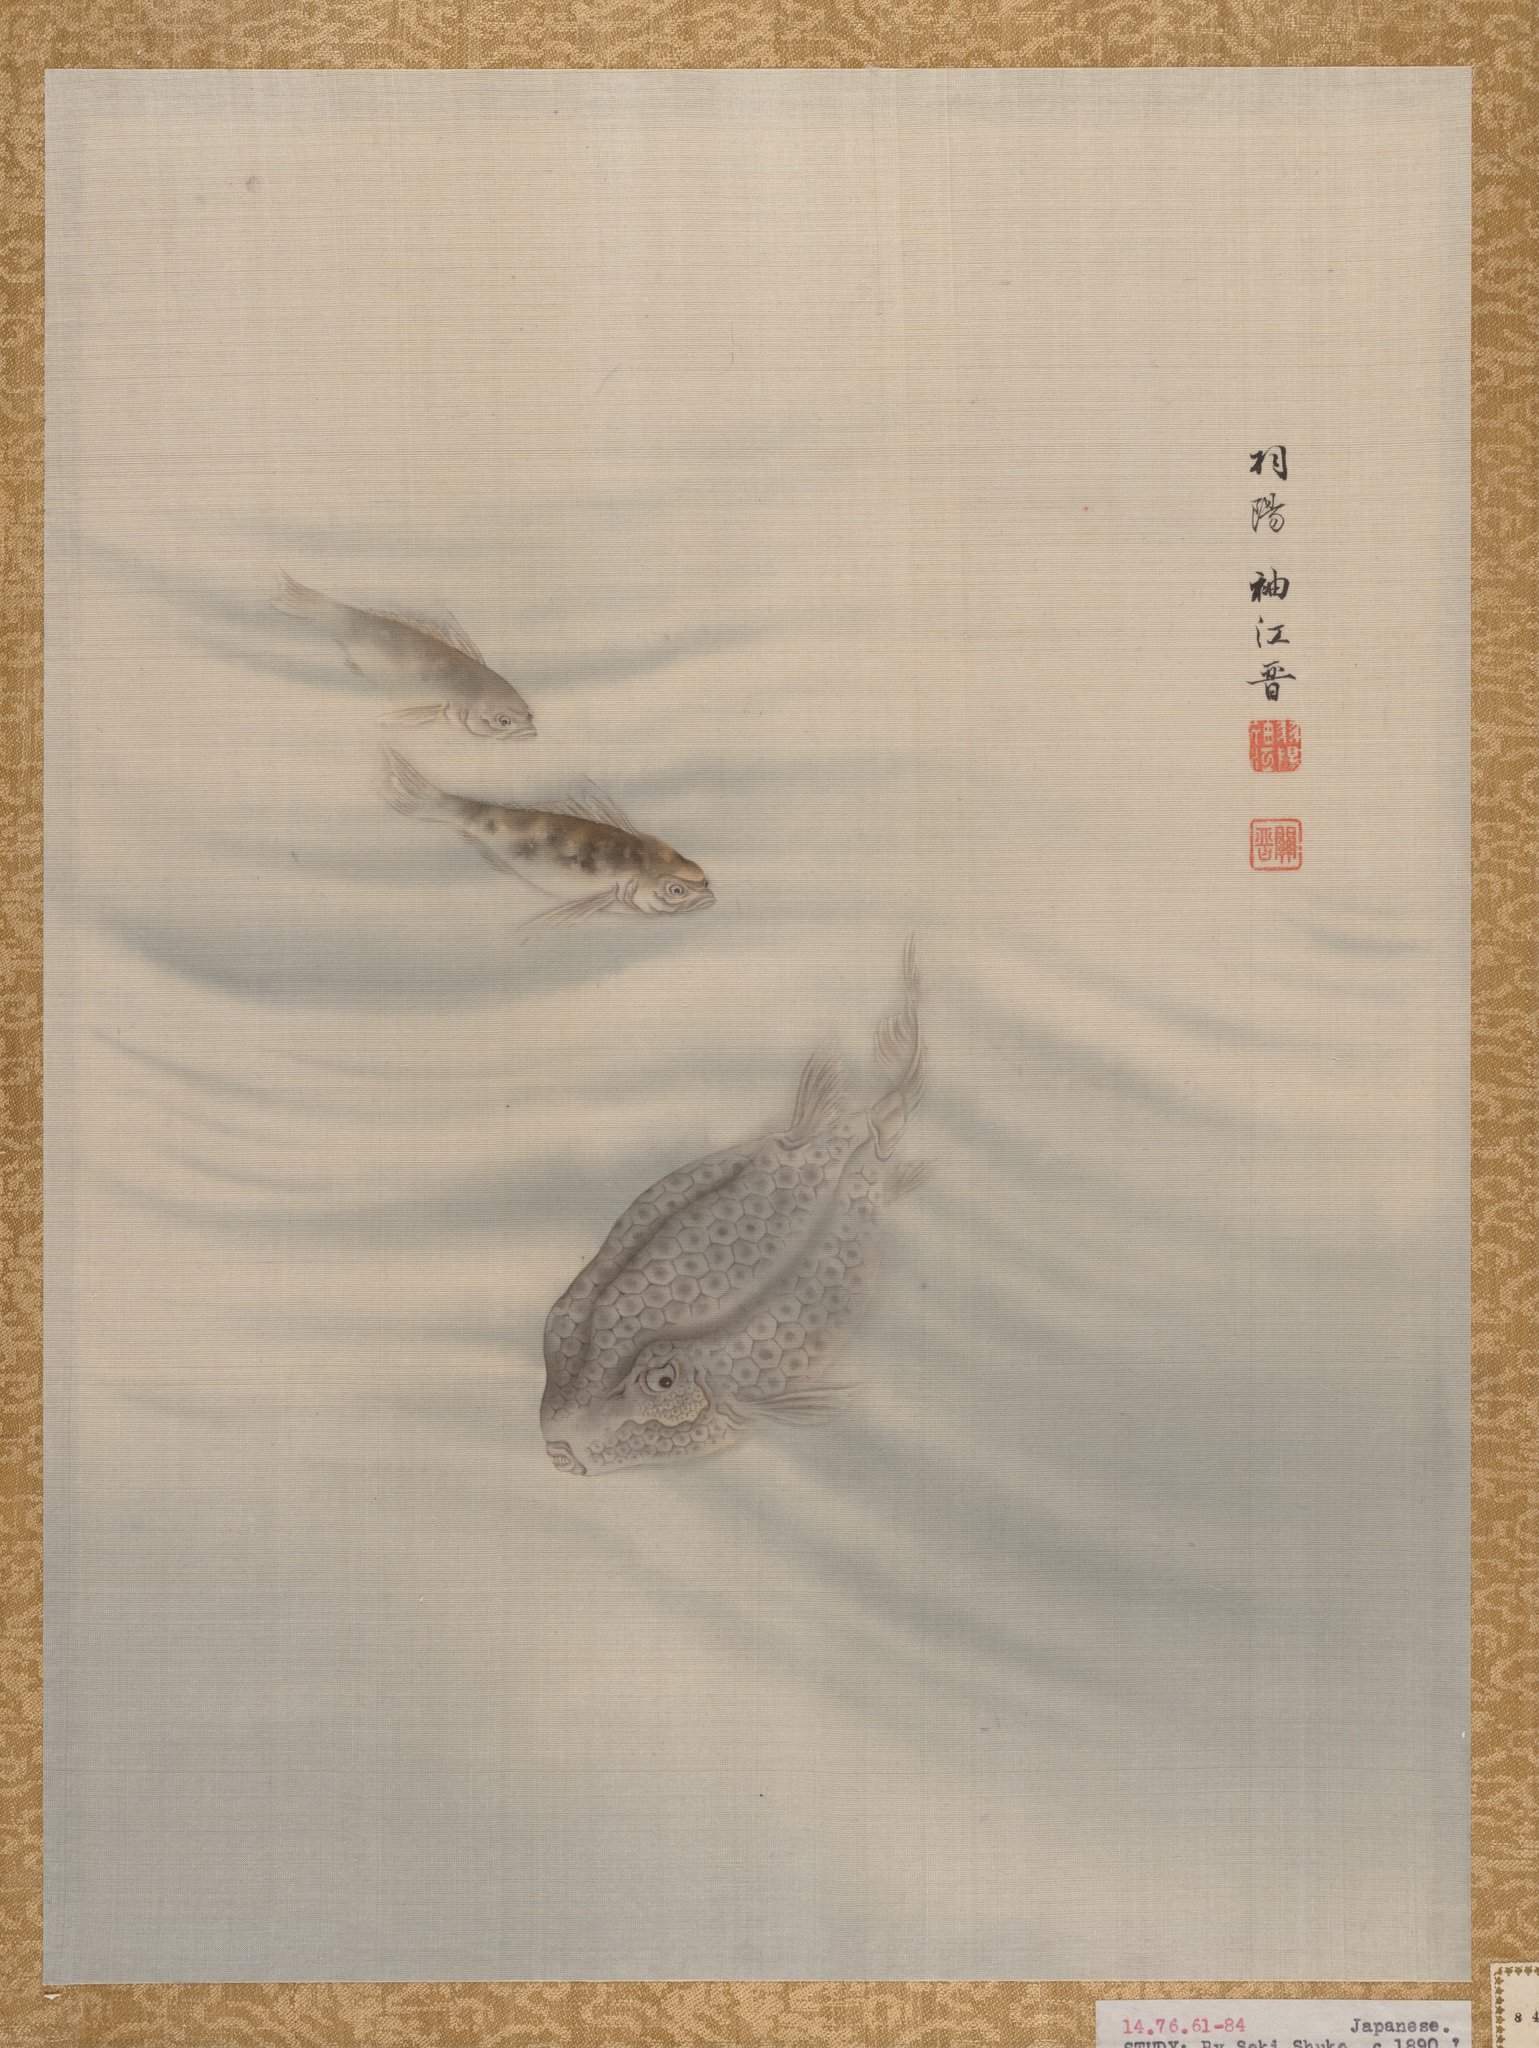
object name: album leaf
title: Fishes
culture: japanese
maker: seki shūkō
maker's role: artist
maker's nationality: japanese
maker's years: 1858-1915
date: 1890-1892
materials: ink, silk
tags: fish